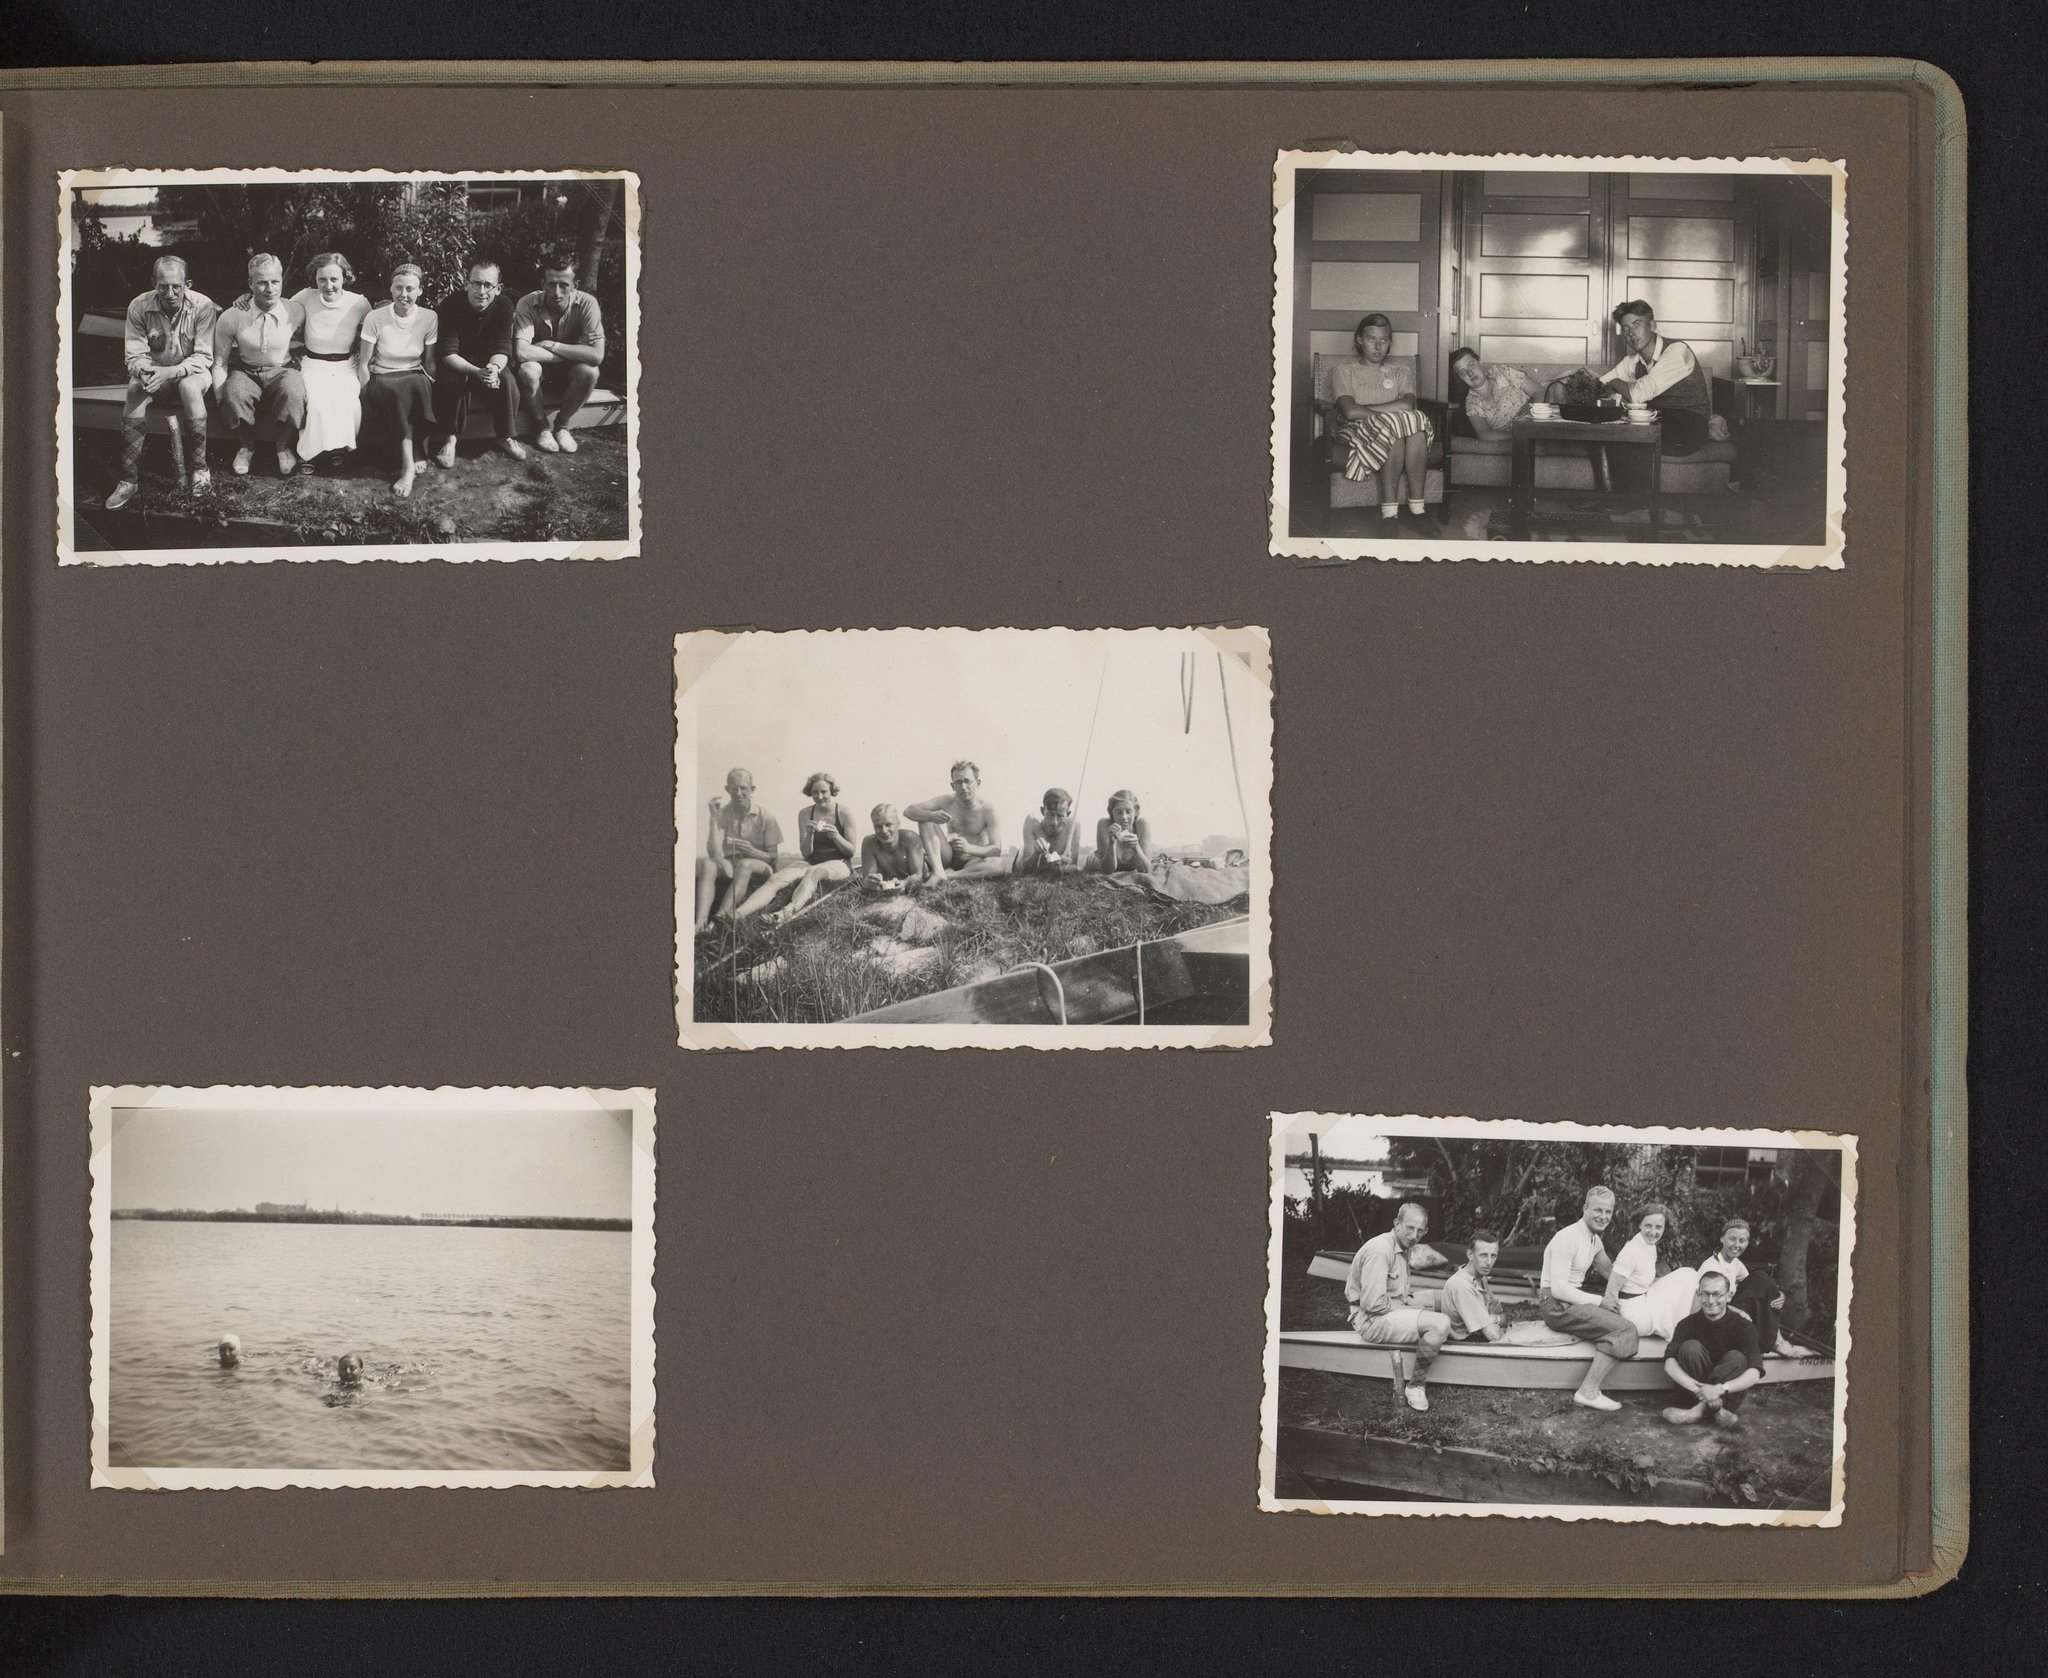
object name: photograph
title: Studenten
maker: Anonymous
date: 1935-1945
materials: cardboard, photographic support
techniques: gelatin silver print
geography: netherlands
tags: student vacation, outing, pleasure trip, netherlands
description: Albumblad met vijf foto's van een vakantie met een groep vrienden. Onderdeel van het fotoalbum van een jonge vrouw, ca. 1935-1945.